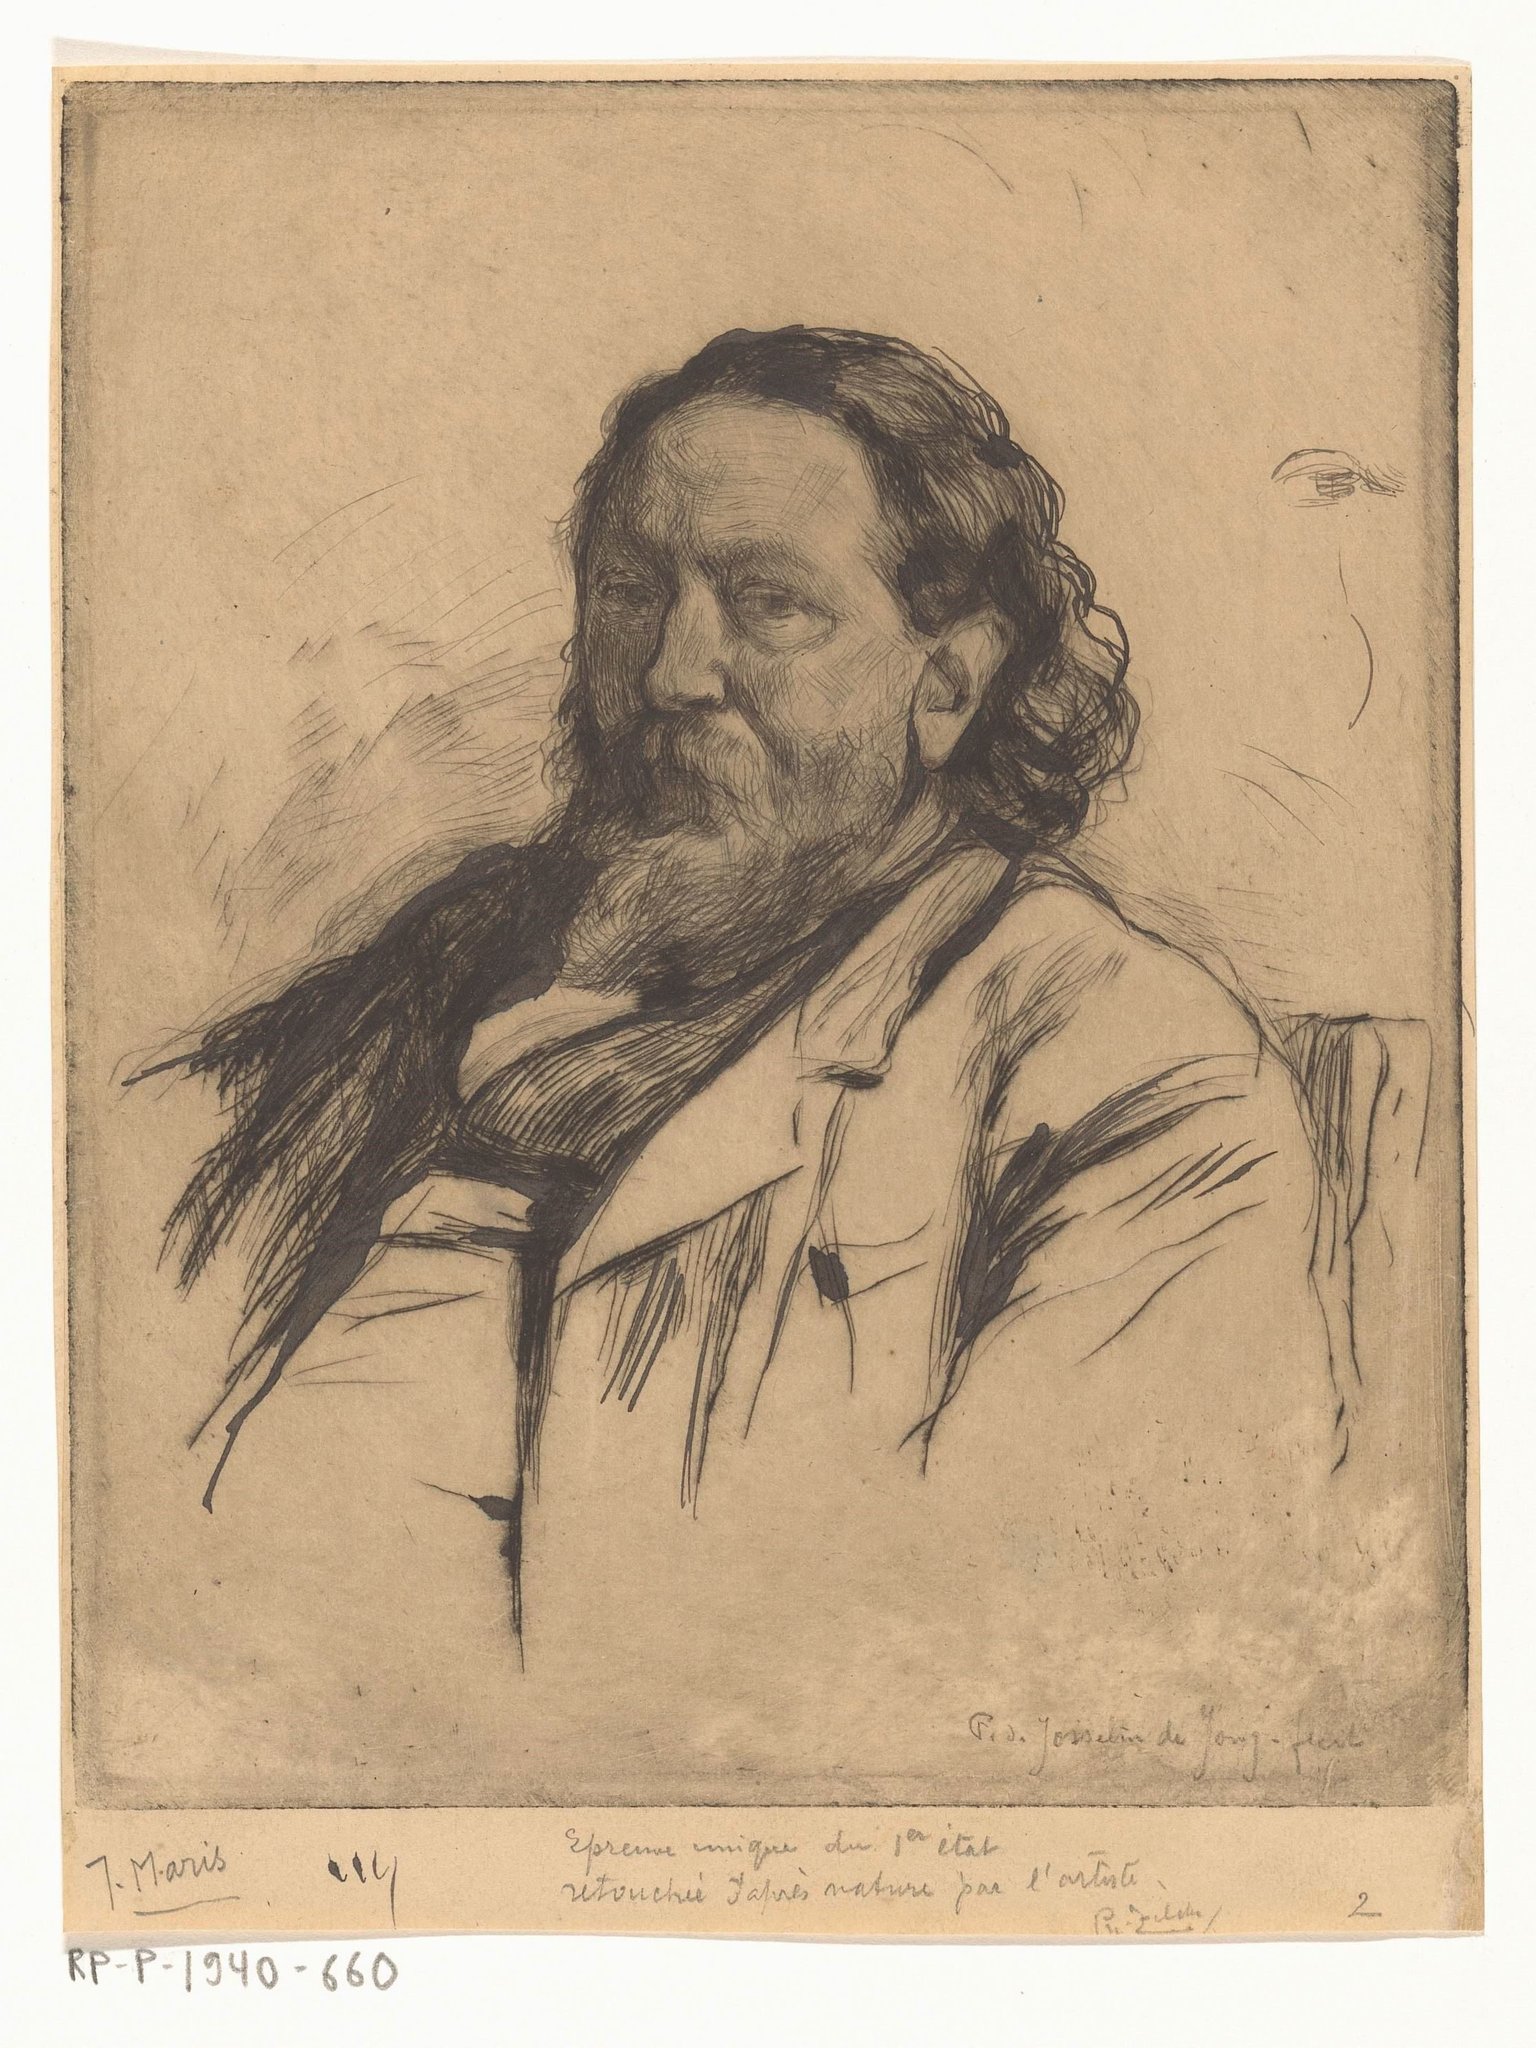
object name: print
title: Portret van Jacob Maris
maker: pieter de josselin de jong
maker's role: draughtsman, painter, print maker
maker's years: 1861-1906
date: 1890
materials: paper, watercolor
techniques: etching, hand coloring, intaglio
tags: painter, jacob maris, portrait, self-portrait of artist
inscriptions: collector's mark: Lugt 2760, collector's mark: Lugt 2228, inscription: ‘Epreuve unique du 1er état, retouchée après nature par l'artiste.’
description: Een portret van kunstenaar Jacob Maris, met baard en snor.